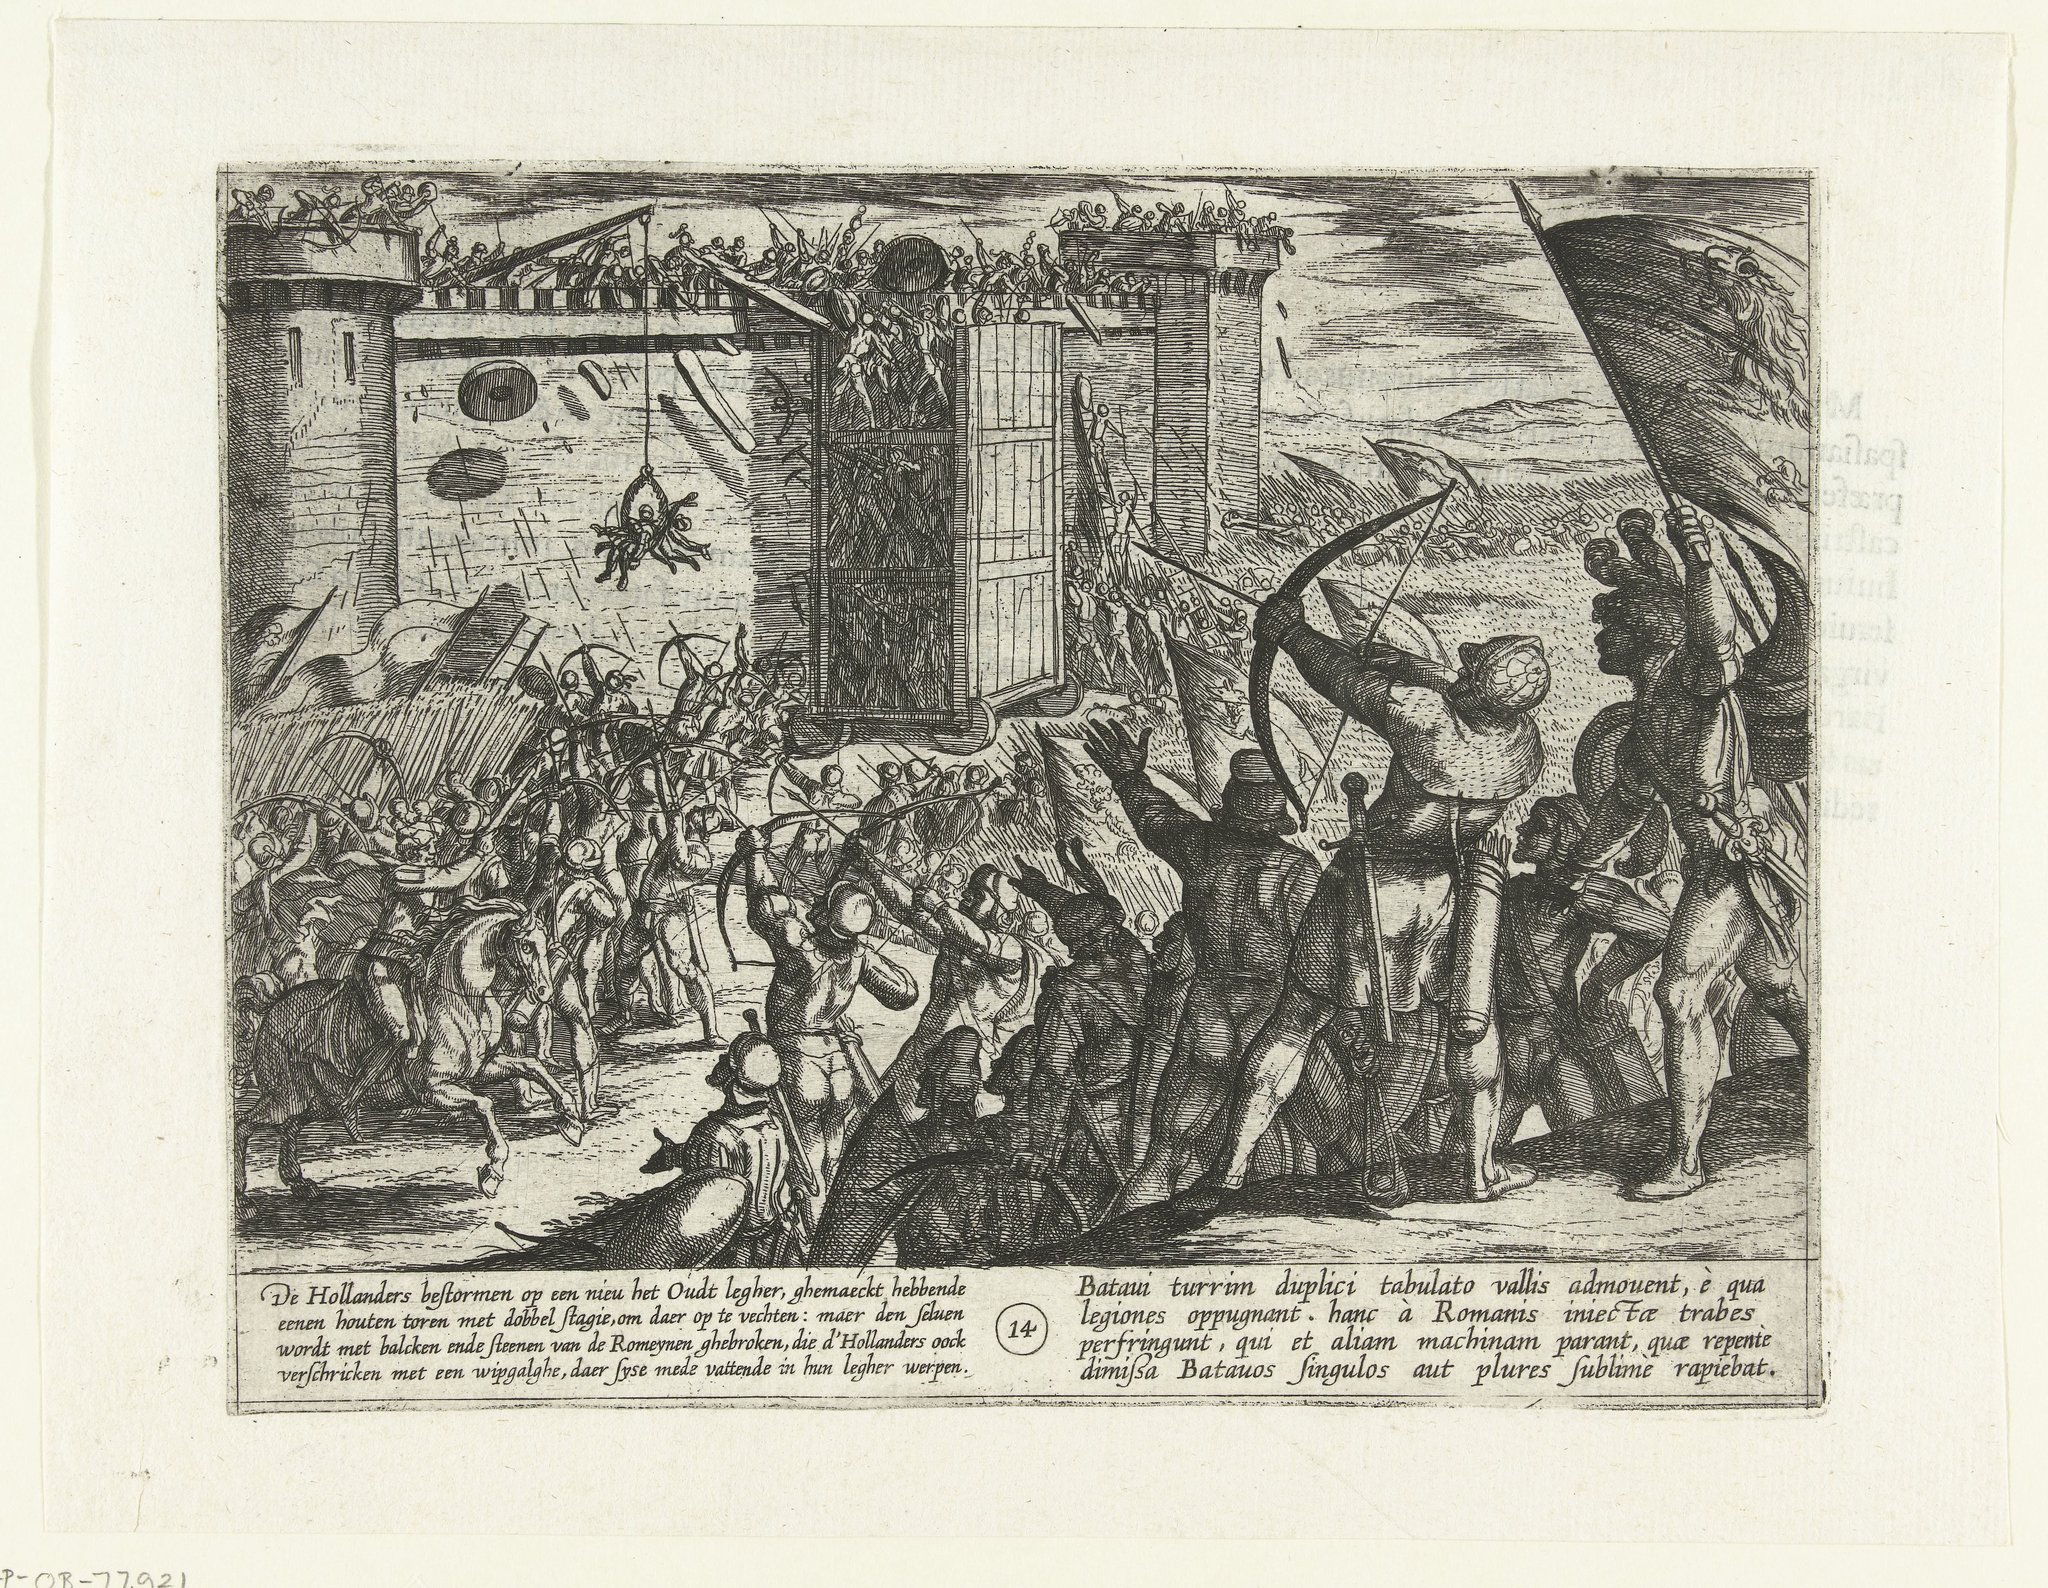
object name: print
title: Nieuwe aanval op een Romeinse vesting, 69-70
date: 1612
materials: paper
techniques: etching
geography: italy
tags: battle, fighting in general, extinct, 'historical' peoples (with name), netherlands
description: Een nieuwe aanval op een Romeinse vesting waarbij gebruik wordt gemaakt van een houten toren. Prent nummer 14 in de serie prenten over de Bataafse Opstand: Batavorum cum Romanis bellum / à Corn. Tacito lib. IV & V. : Hist. olim descriptum, figuris nunc aeneis expressum, auctore Othone Vaenio Lugdunobatava = De Batavische oft oude Hollandtsche oorloghe teghen de Romeynen. Otto Vaenius, Antwerpen 1612. Onderaan twee verzen van vier regels in het Nederlands en in het Latijn. Op de achterzijde tekst in het Latijn.